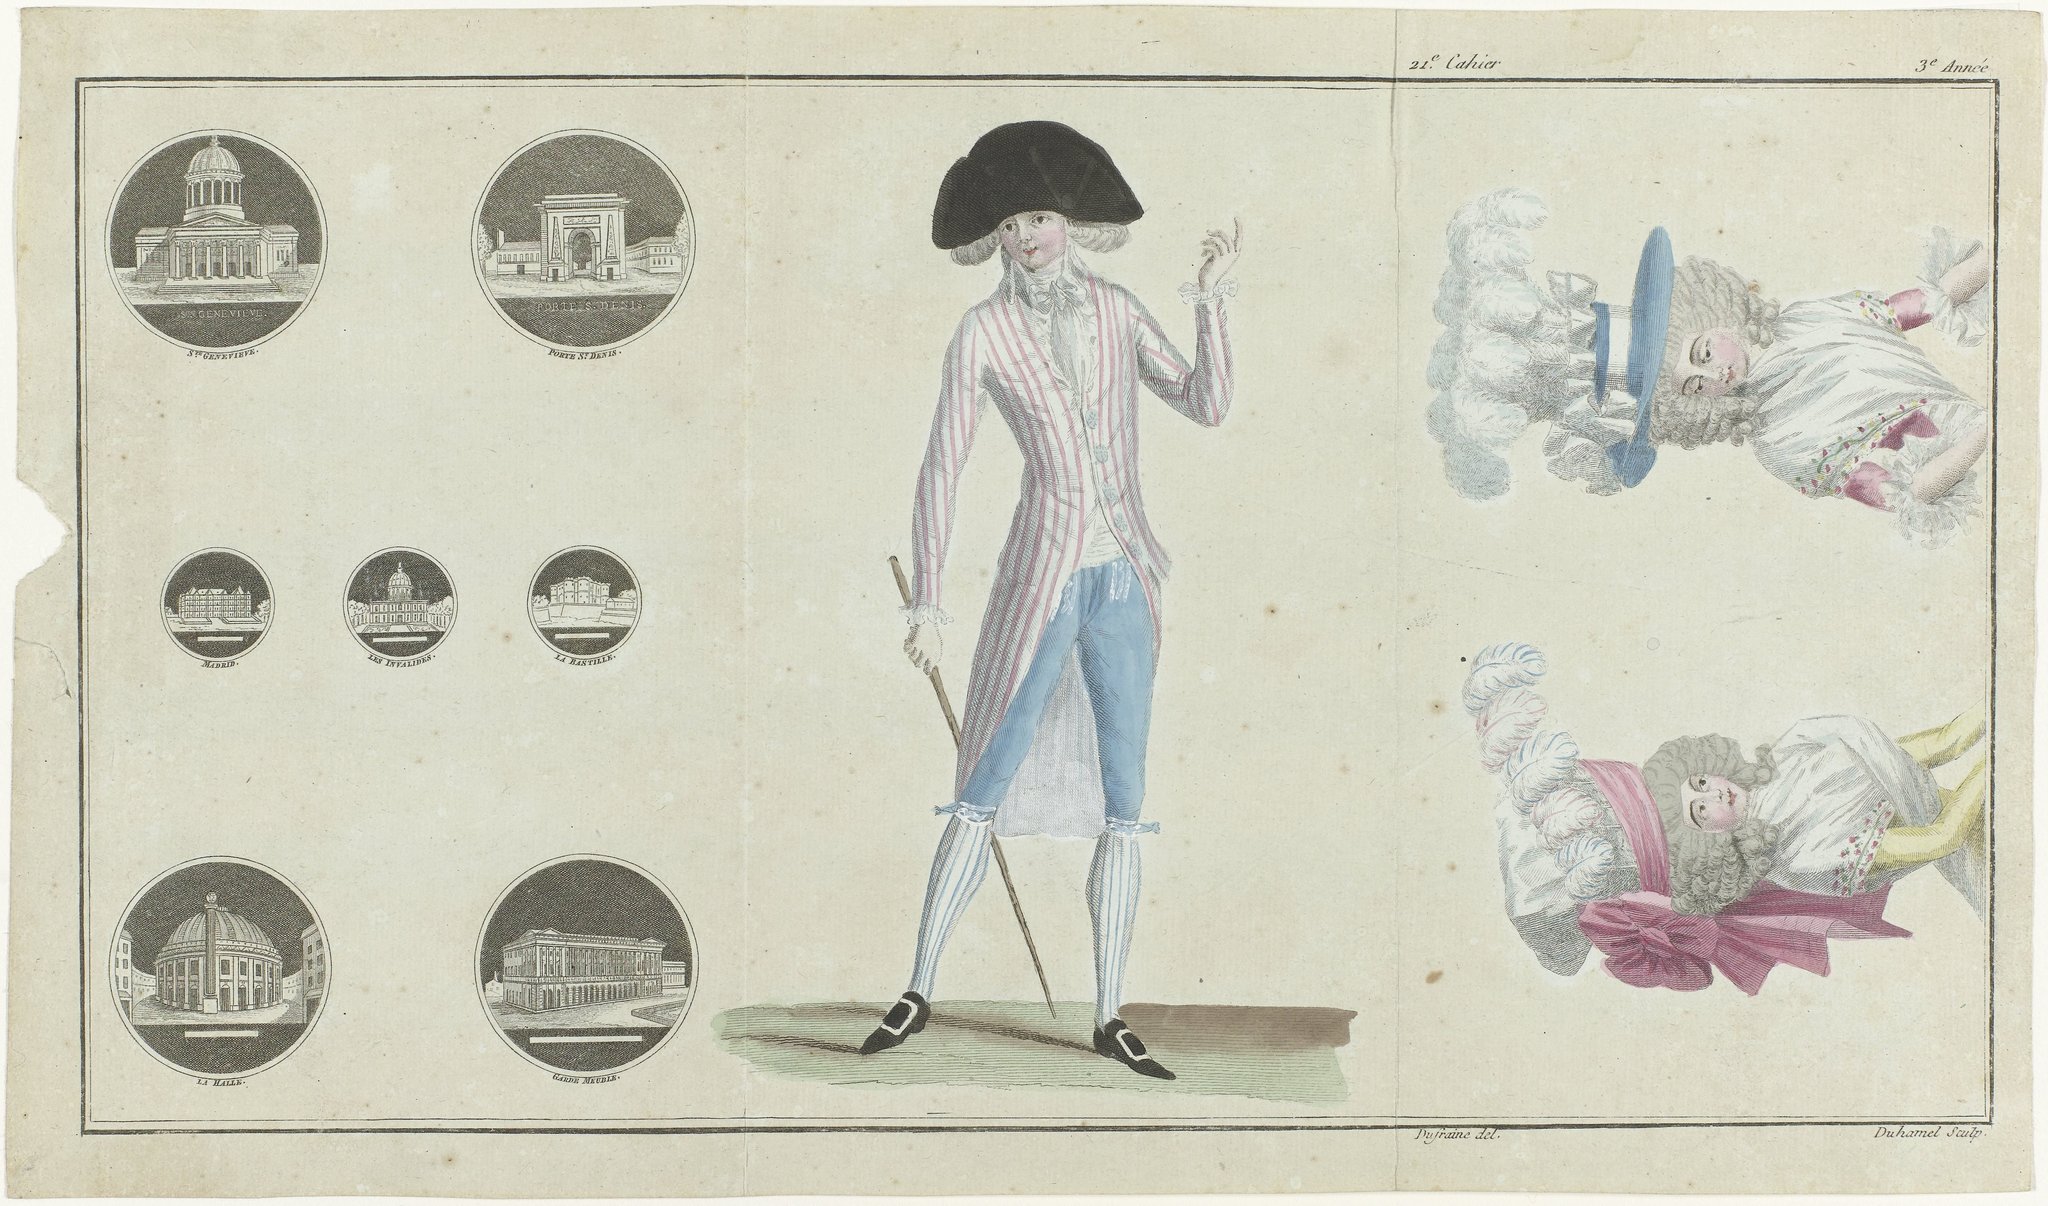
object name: fashion print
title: Magasin des Modes Nouvelles Françaises et Anglaises, 10 juin 1788, 3e Année, 21e cahier, Pl. 1, 2 et 3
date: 1788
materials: paper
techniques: engraving, hand coloring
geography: paris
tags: clothing for the upper part of the body (vest) (+ men's clothes), button, head-gear (pouf) (+ women's clothes), border, ribbon, braid (+ women's clothes), coat (+ men's clothes), fashion plates, head-gear: hat (+ women's clothes), shoes, sandals (+ men's clothes), trousers, breeches, etc. (breeches) (+ men's clothes), stockings, socks (+ men's clothes), walking-stick, staff, cane (+ men's clothes), head-gear: bicorne, bicorn (+ men's clothes)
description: Van links naar rechts. Zeven knopen met: 1) de kerk van Sainte-Geneviève, 2) de stadspoort van Saint-Denis 3) het kasteel van Madrid, 4) Hôtel des Invalides, 5) de Bastille, 6) Halle aux blés, 7) Hôtel du Garde-Meuble. Jongeman gekleed in een gestreepte habit met grote knopen, vest en blauwe kniebroek. Gestrikte halsdoek, gerimpelde jabot en manchetten. Gestreepte kousen. Accessoires: steek met knoop en lis, wandelstok, schoenen met vierkante gespen. Twee vrouwenbustes: onder: muts van wit gaas met roze band en vederbos; boven: blauwe hoed met brede rand met wit lint. De prent maakt deel uit van het 21e Cahier, 3e année, uit Magasin des Modes Nouvelles Françaises et Anglaises. De serie bestaat uit 172 modeprenten, uitgegeven door Buisson, Parijs, 20 november 1786 - 21 décembre 1789.